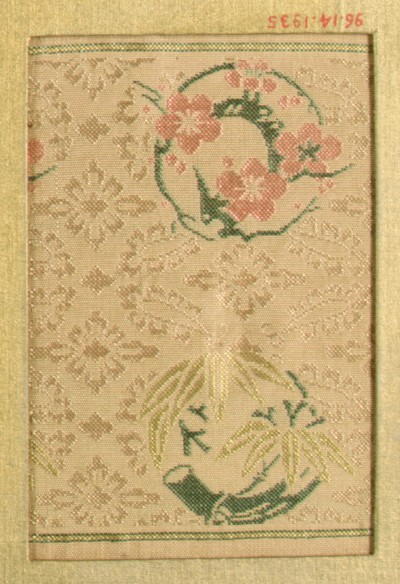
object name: piece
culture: japanese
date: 1701-1900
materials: silk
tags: flowers